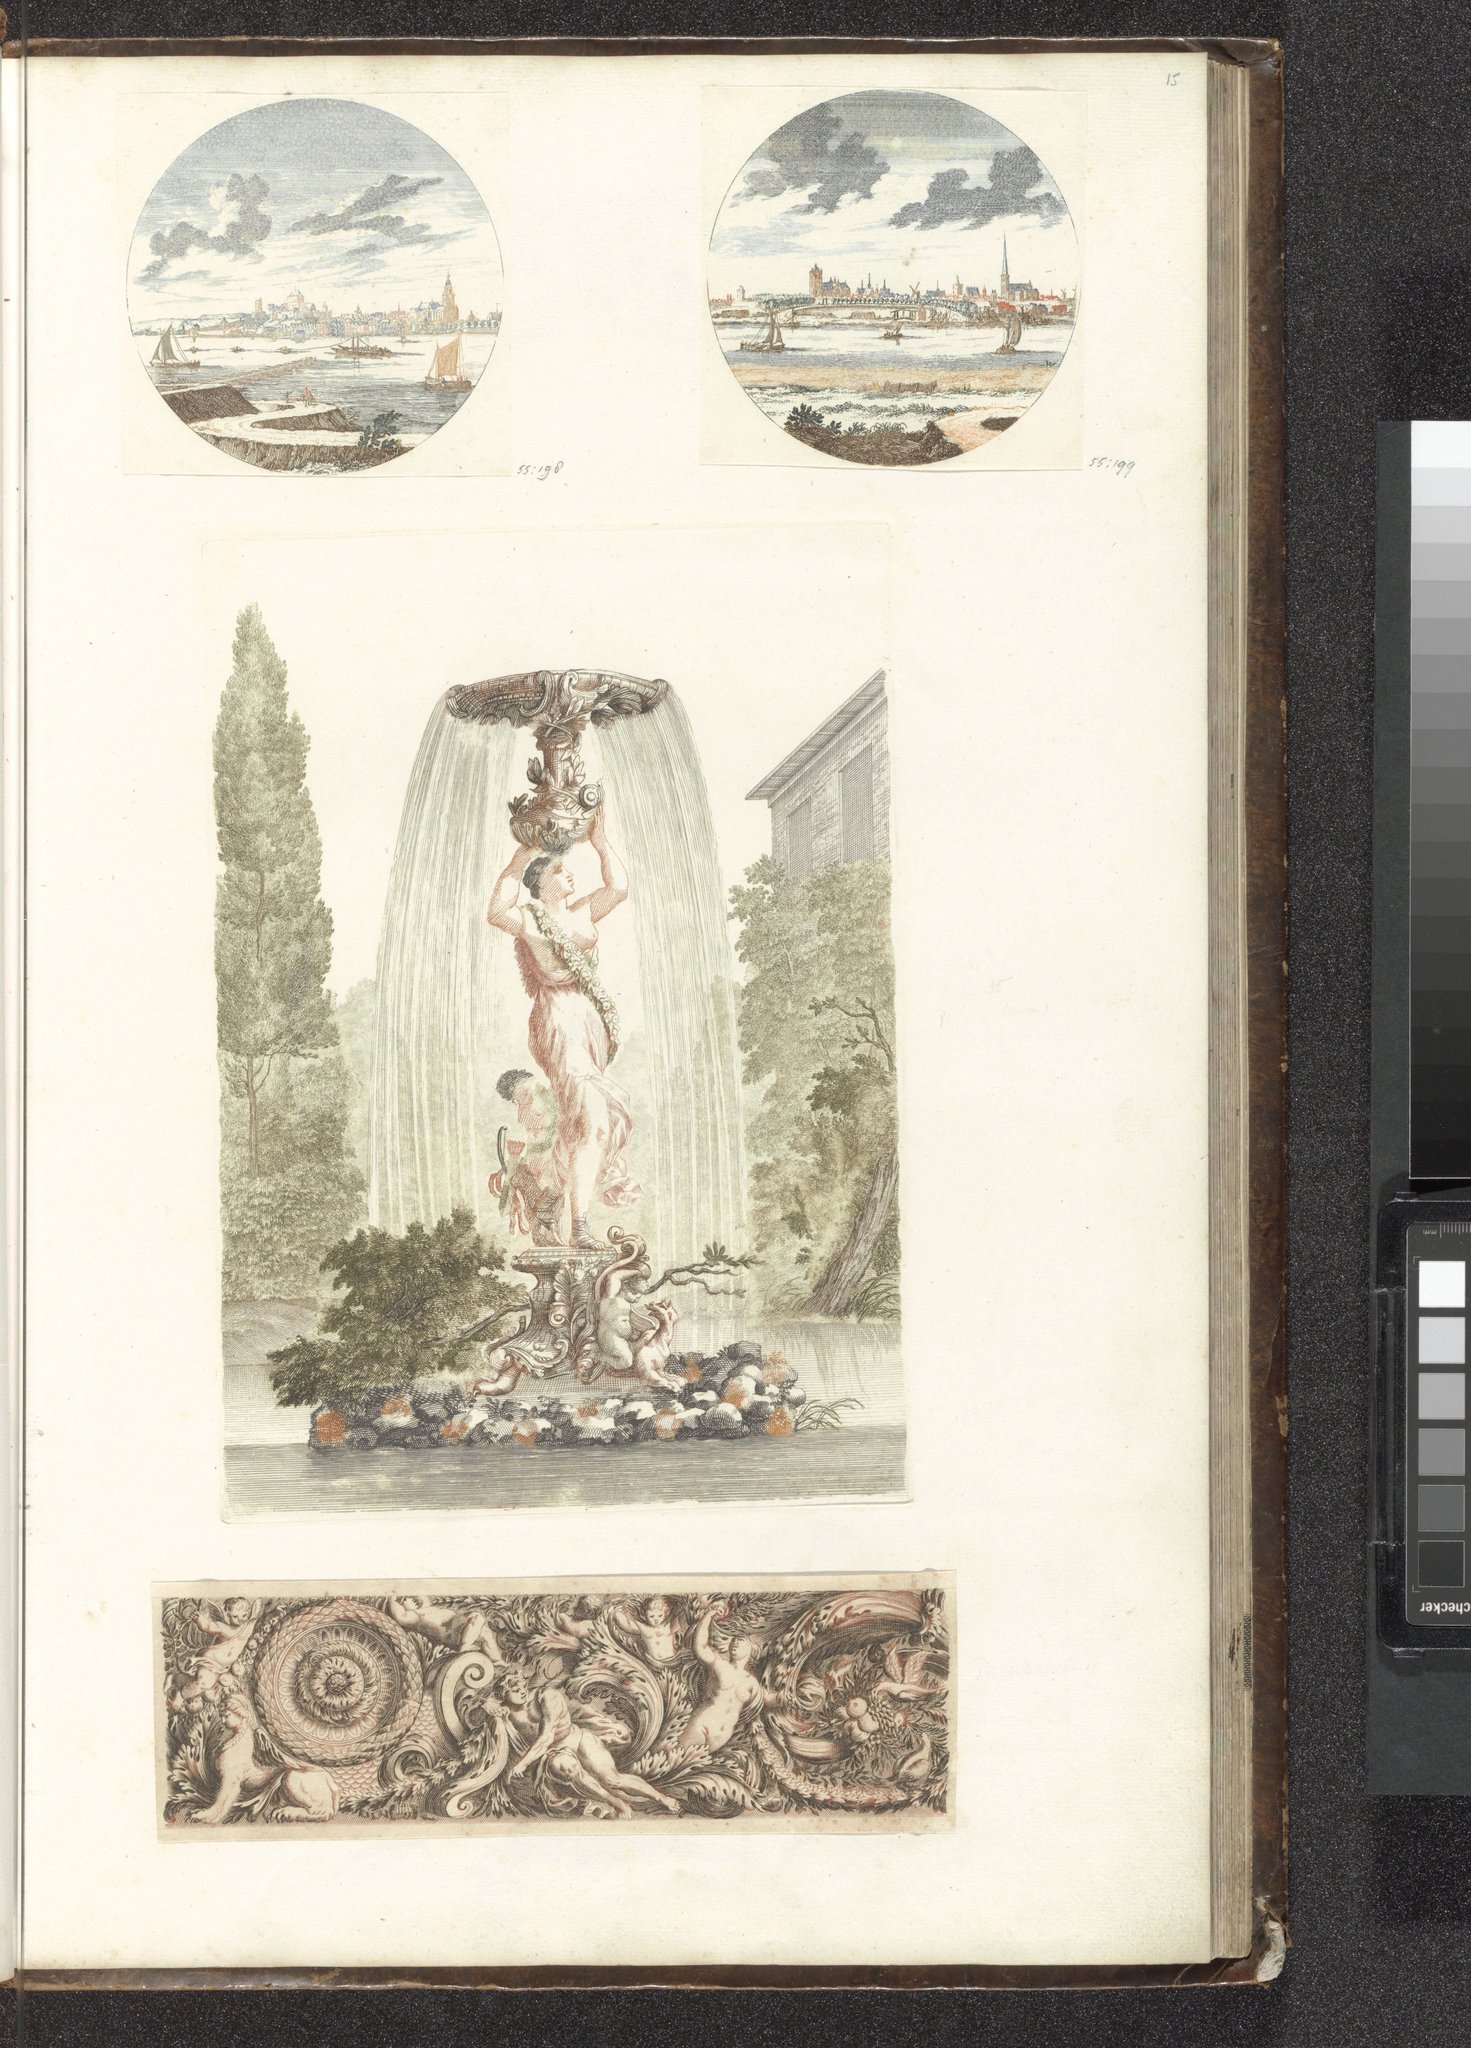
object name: album leaf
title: Gezicht op Emmerich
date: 1688-1698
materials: paper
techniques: etching, lithography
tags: city-view in general; 'veduta', river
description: Gezicht op Emmerich. Op de voorgrond de rivier de Rijn. Deze prent maakt deel uit van een album.